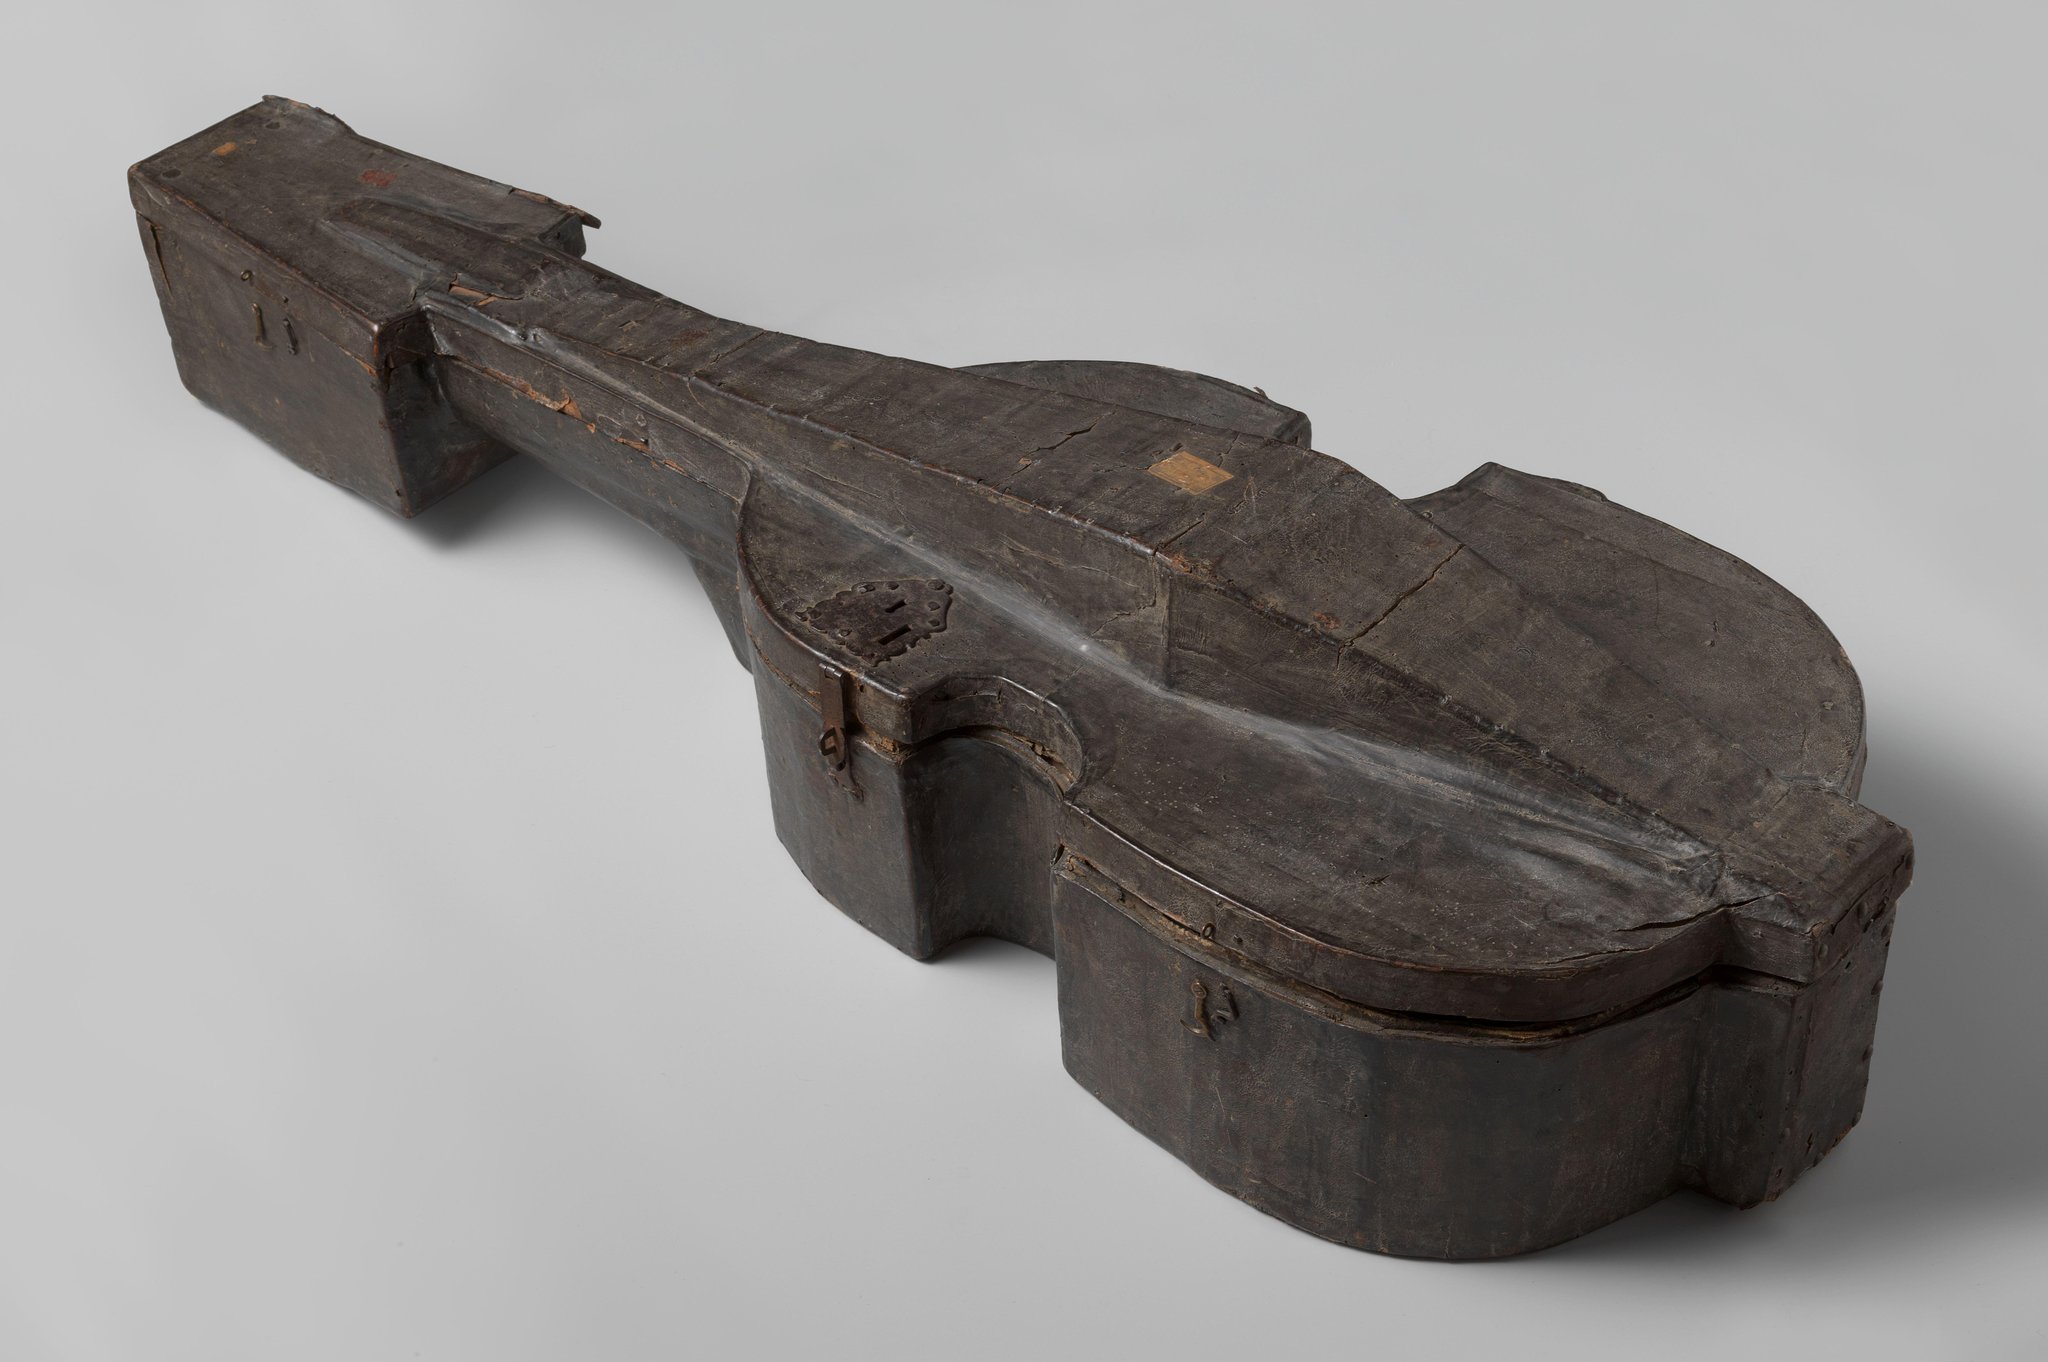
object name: musical instrument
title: Bass viol case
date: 1700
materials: wood, intestine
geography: amsterdam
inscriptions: signature: ‘UTR....’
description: Kist horend bij zevensnarige basgamba (BK-KOG-1347-B-1).